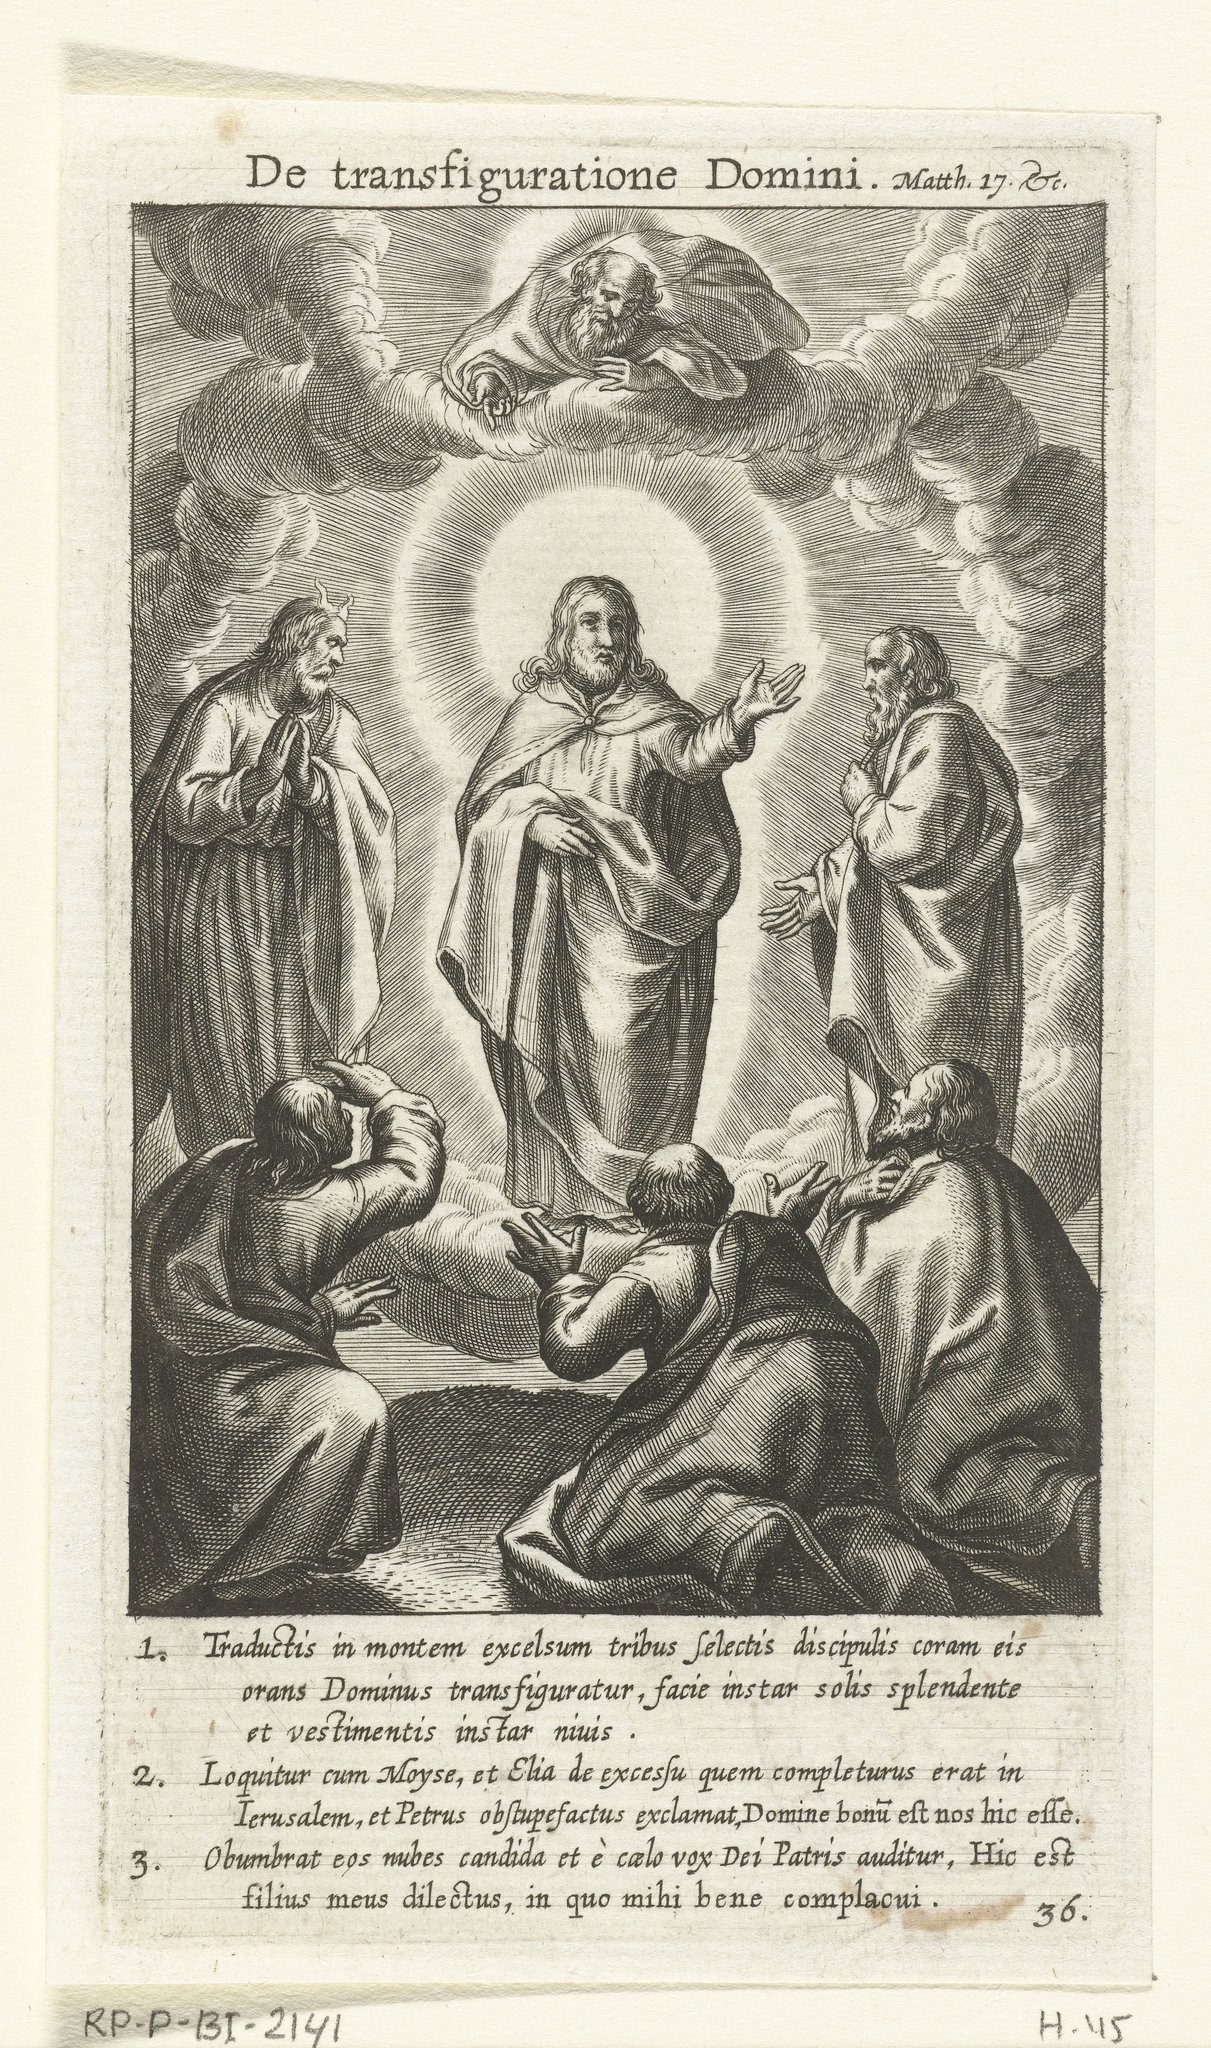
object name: book illustration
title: Transfiguratie van Christus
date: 1590-1622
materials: paper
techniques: engraving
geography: antwerp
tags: the transfiguration: moses and elijah appear on either side of christ on mount tabor (matthew 17:1-13; mark 9:2-13; luke 9:28-36)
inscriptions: collector's mark: Lugt 240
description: Prent uit: Joannes Bourgois, Vitae passionis et mortis Jesu Christi Somini nostri mysteria, Antwerpen Hendrick Aertssens, 1622, afb. 36